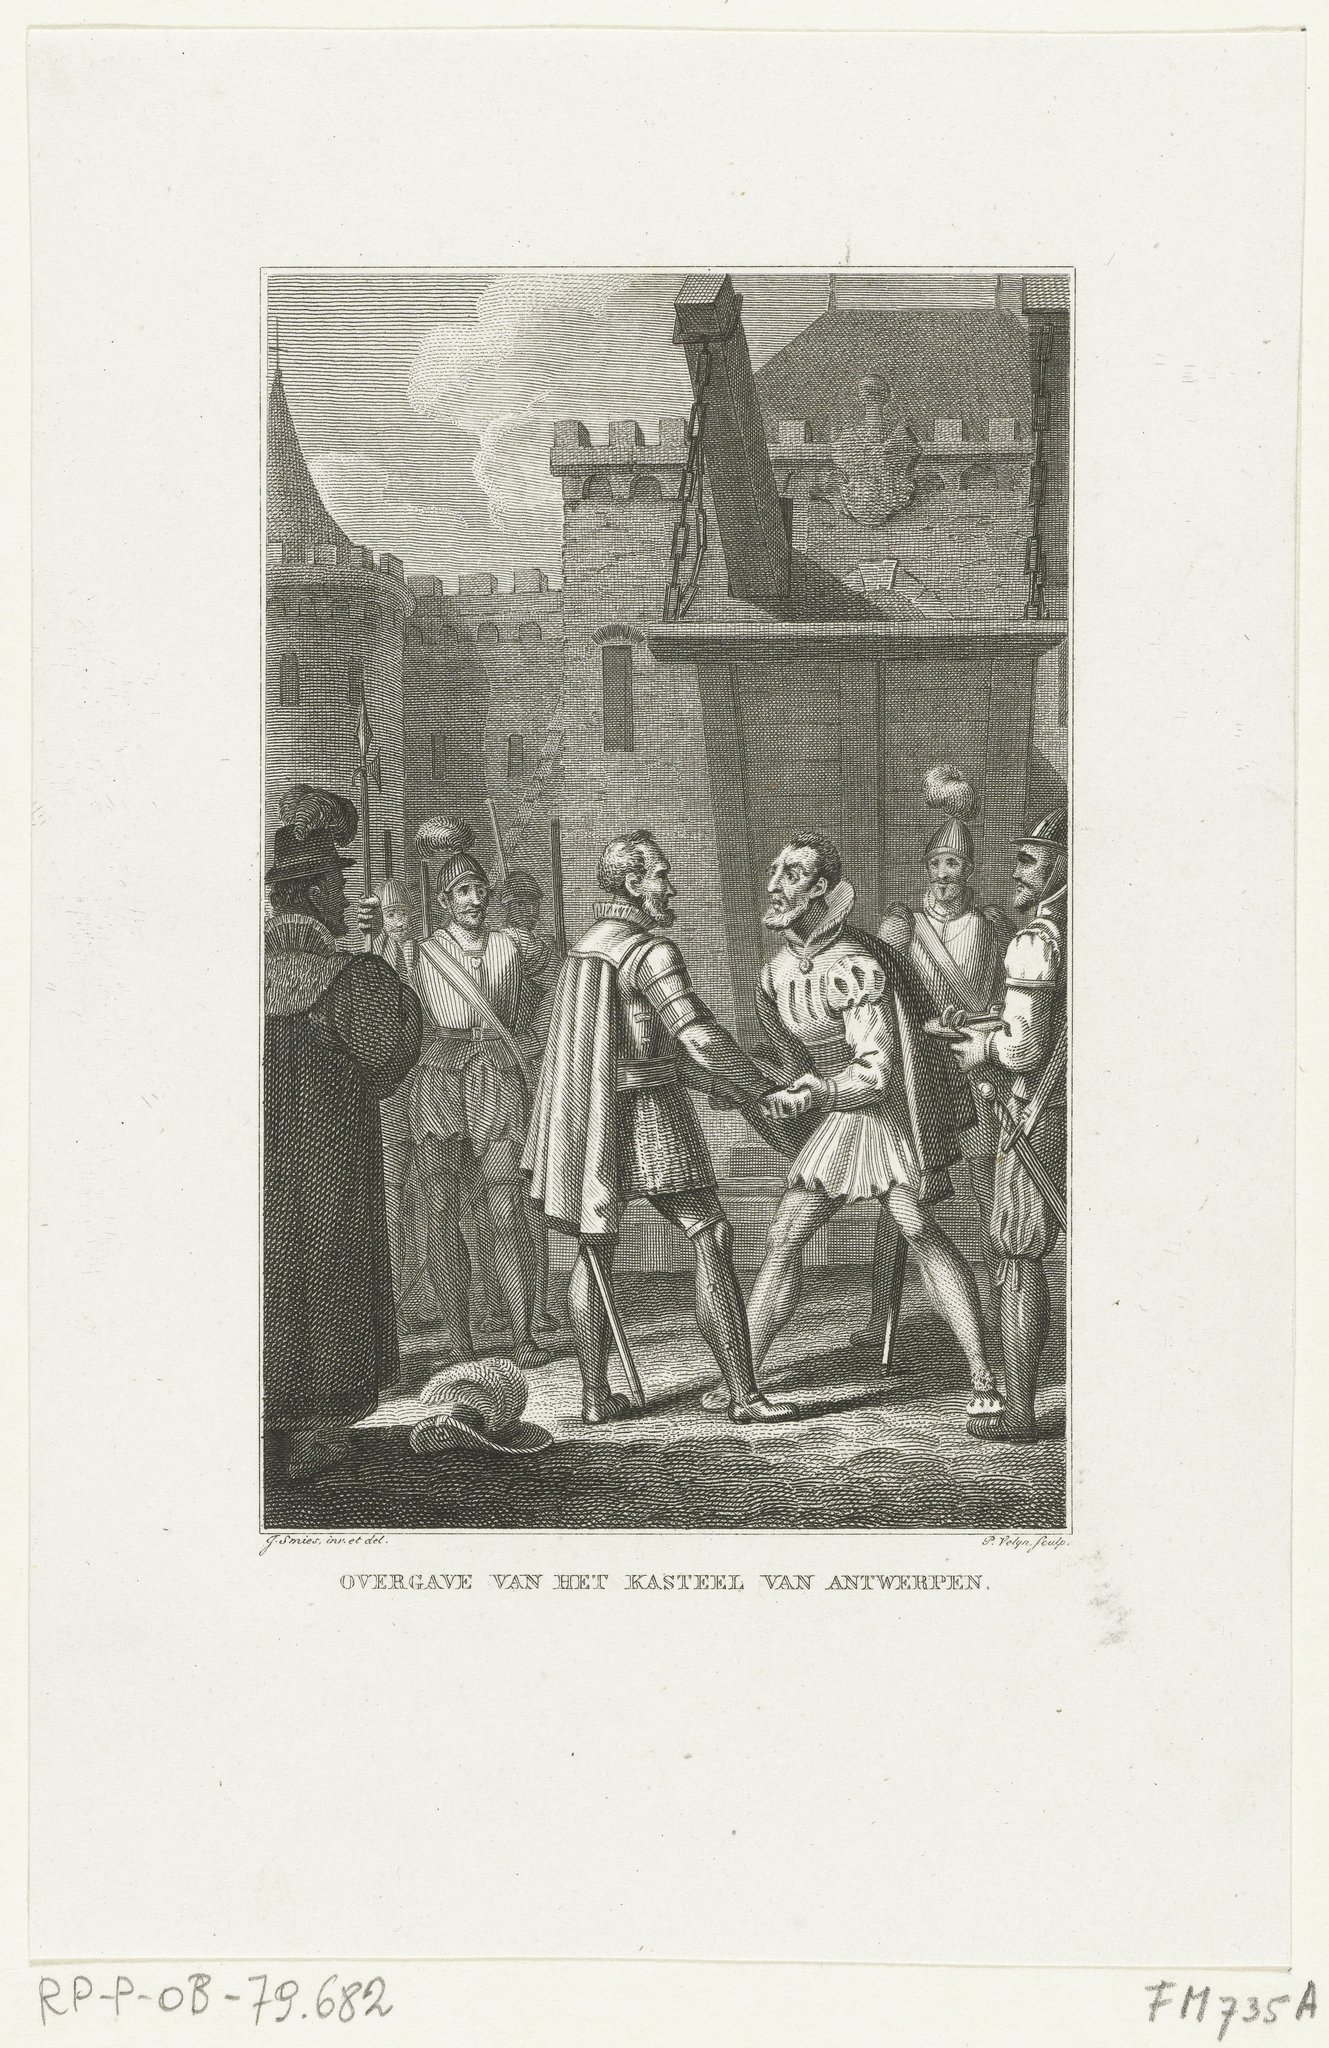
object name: history print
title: Aftocht van Spanjaarden uit Antwerpen, 1577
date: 1823-1829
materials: paper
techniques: pen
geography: netherlands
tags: venice, earl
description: Illustratie voor: P.G. Witsen Geysbeek en G. Engelberts Gerrits, Schoonheden en merkwaardige tafereelen uit de Nederlandsche geschiedenis. G. Portielje, Amsterdam 1825-1829, 8 delen.